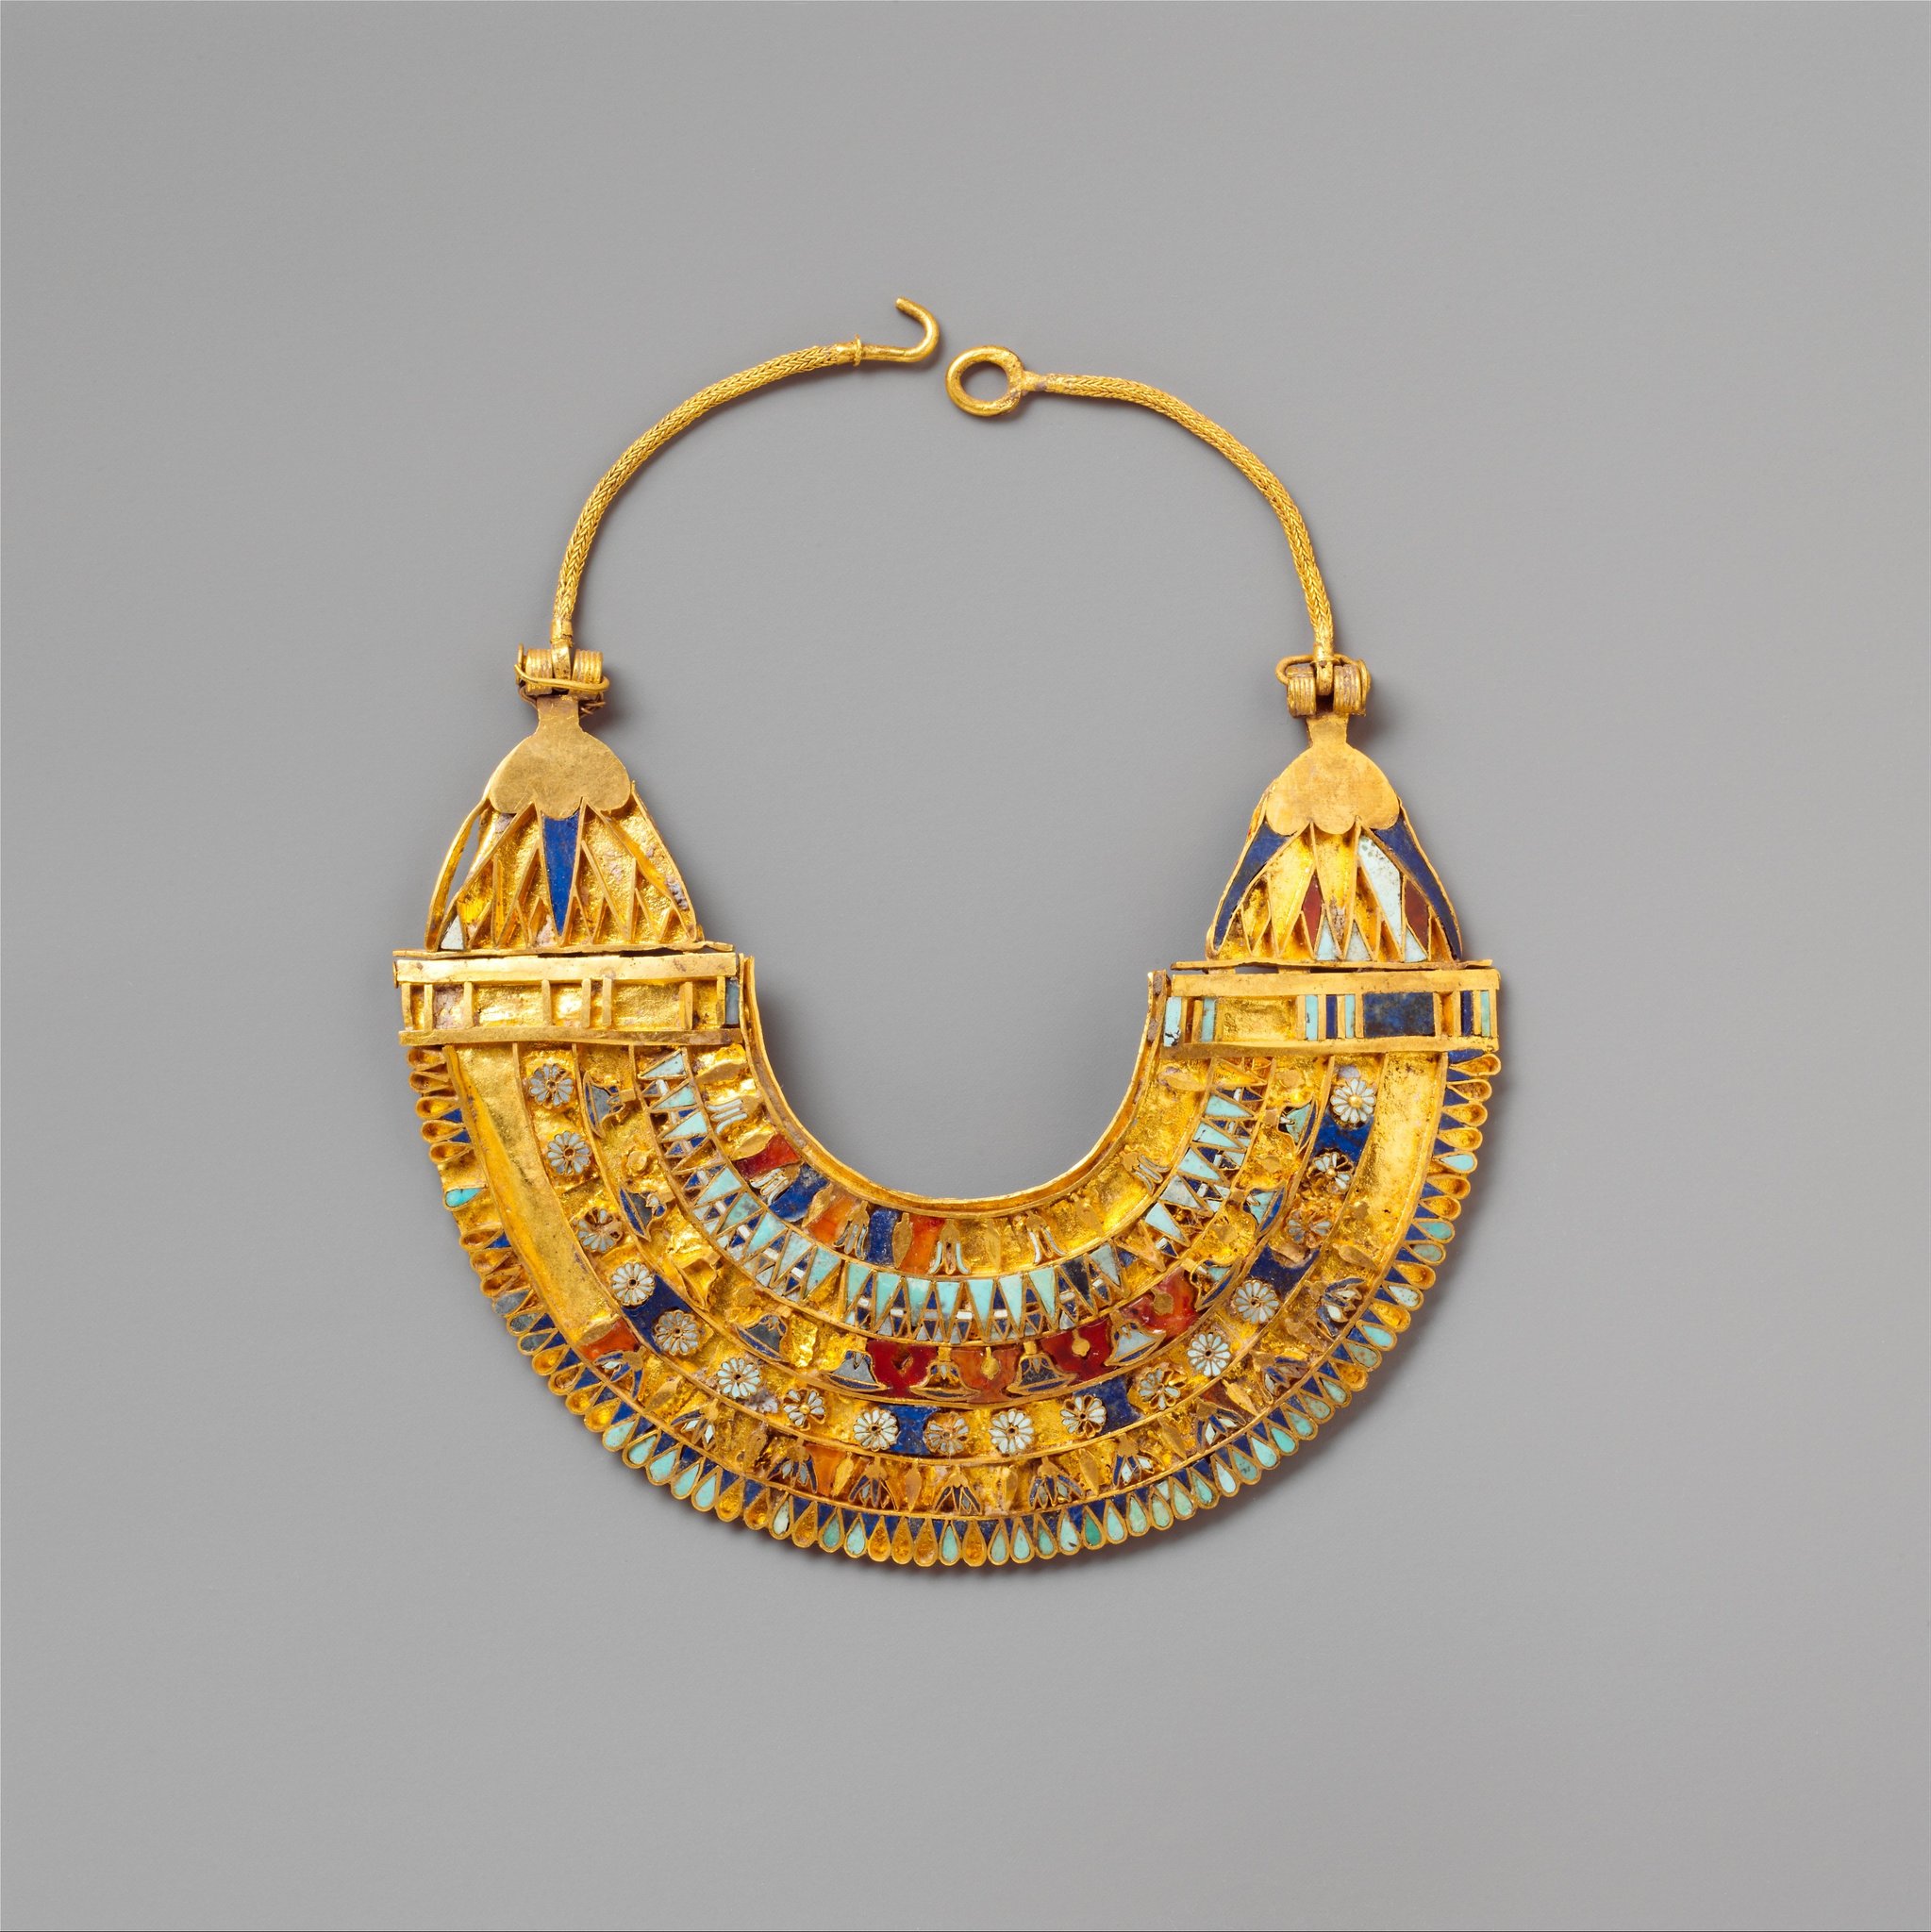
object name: necklace, broad collar, miniature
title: Miniature broad collar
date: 332-246 BCE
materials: gemstone, gold, lapis lazuli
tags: lotuses